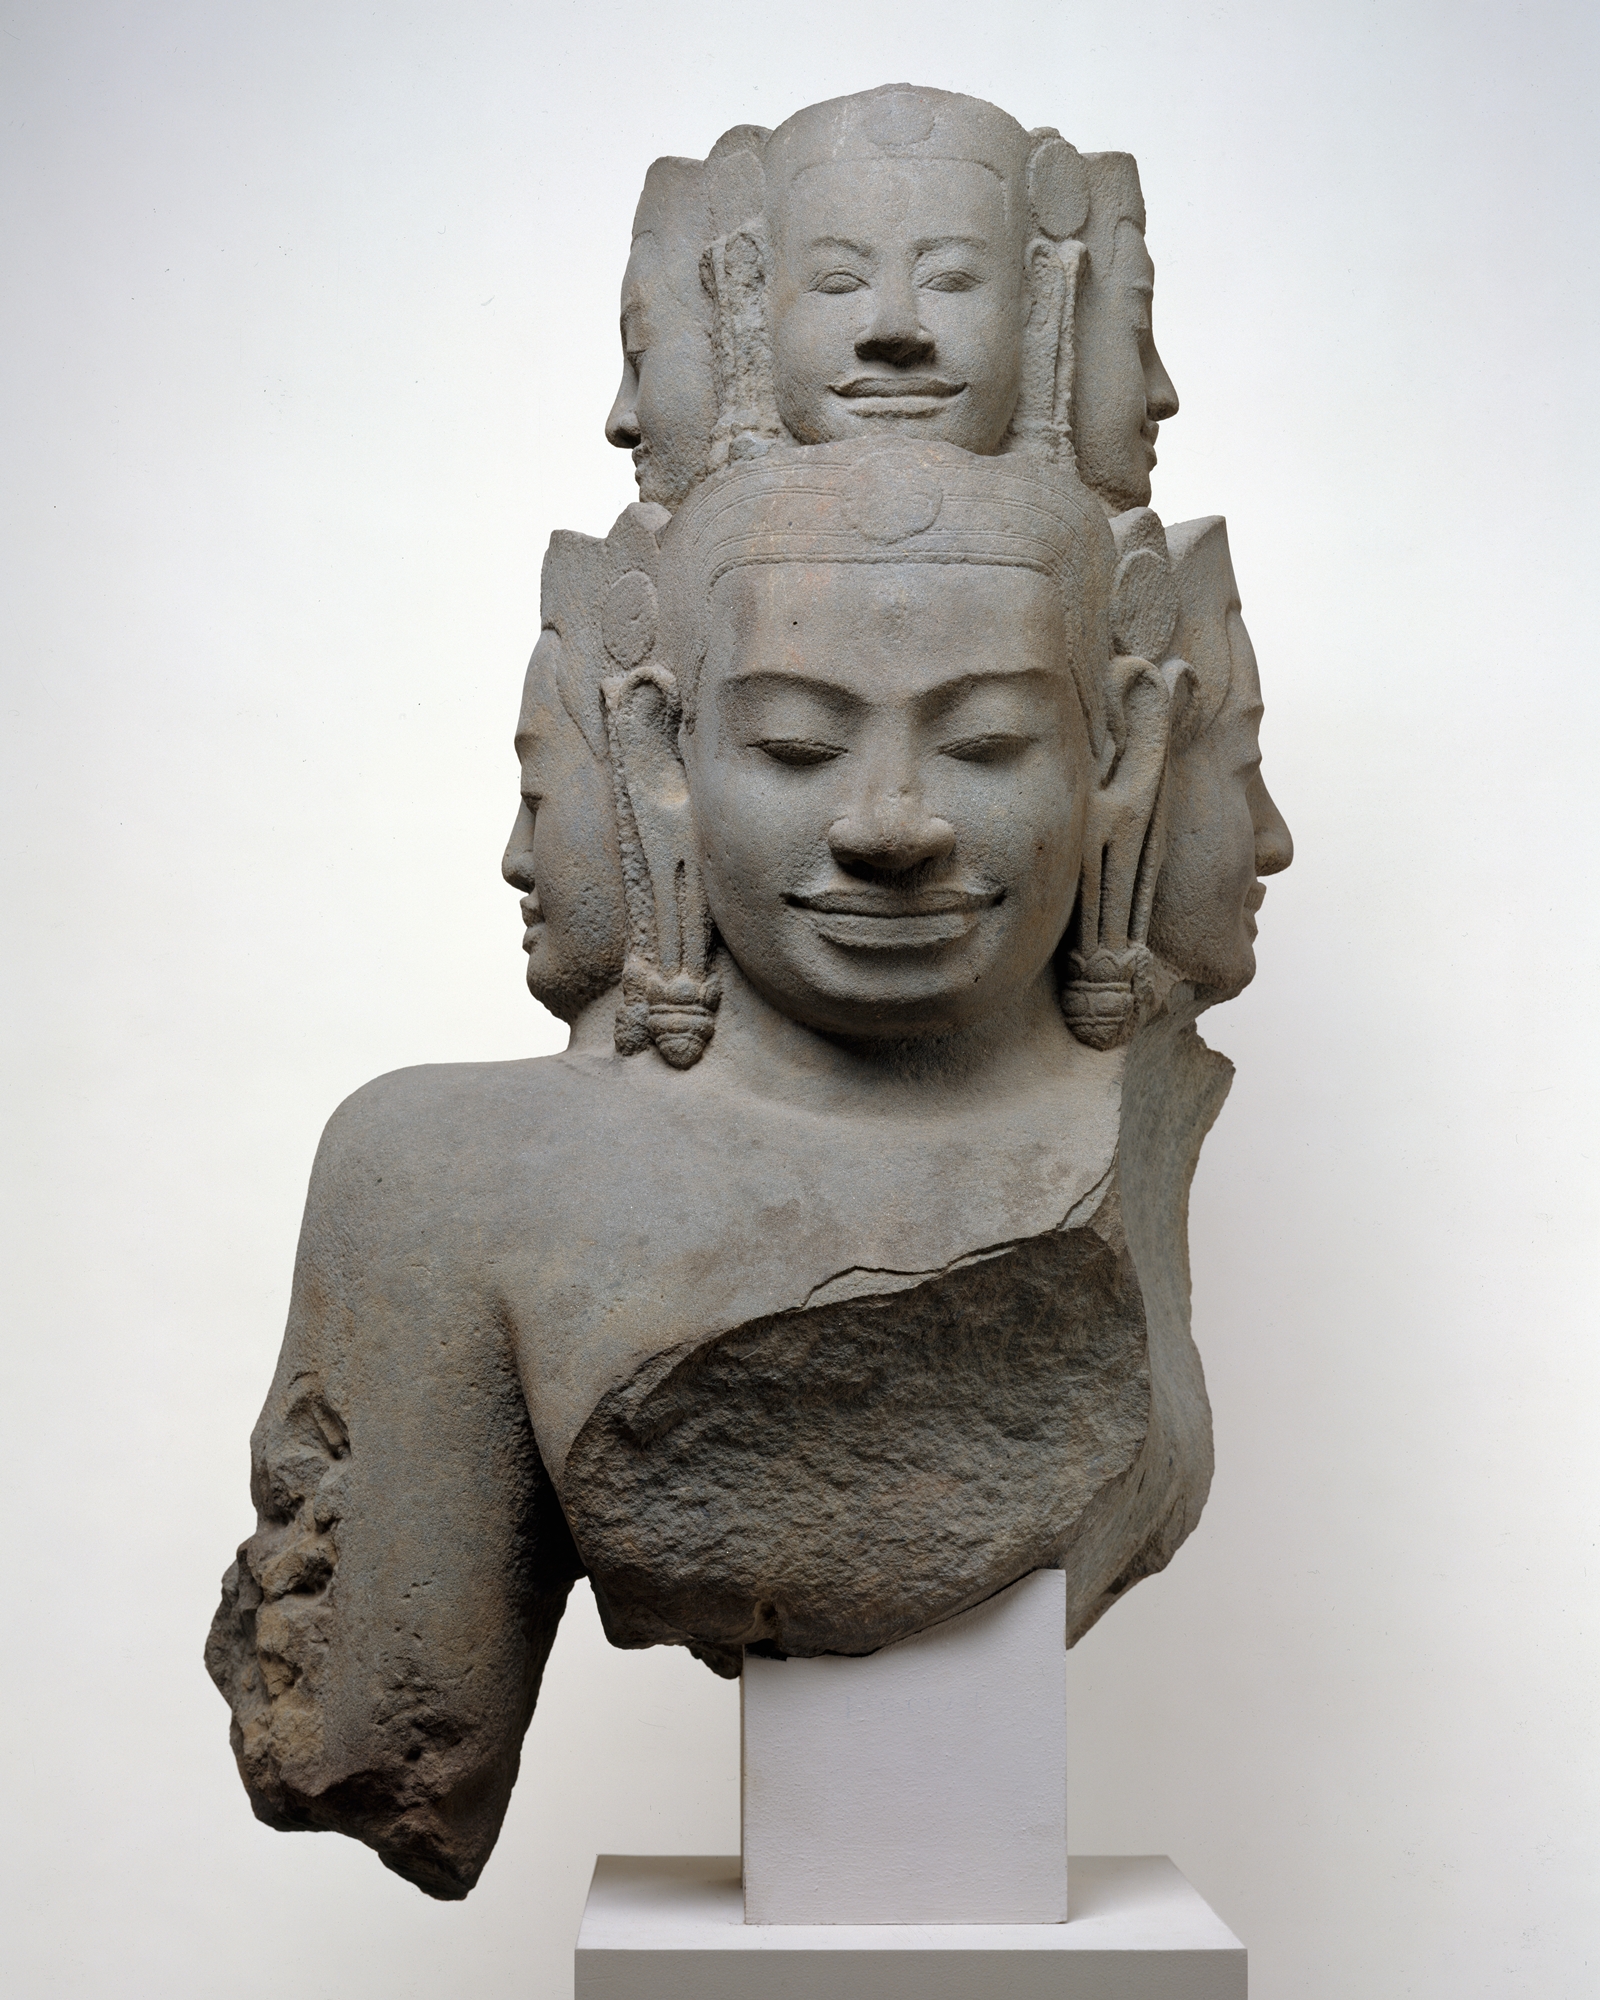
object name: bust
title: Bust of Hevajra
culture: cambodian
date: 1167-1233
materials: stone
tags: buddhism,deities